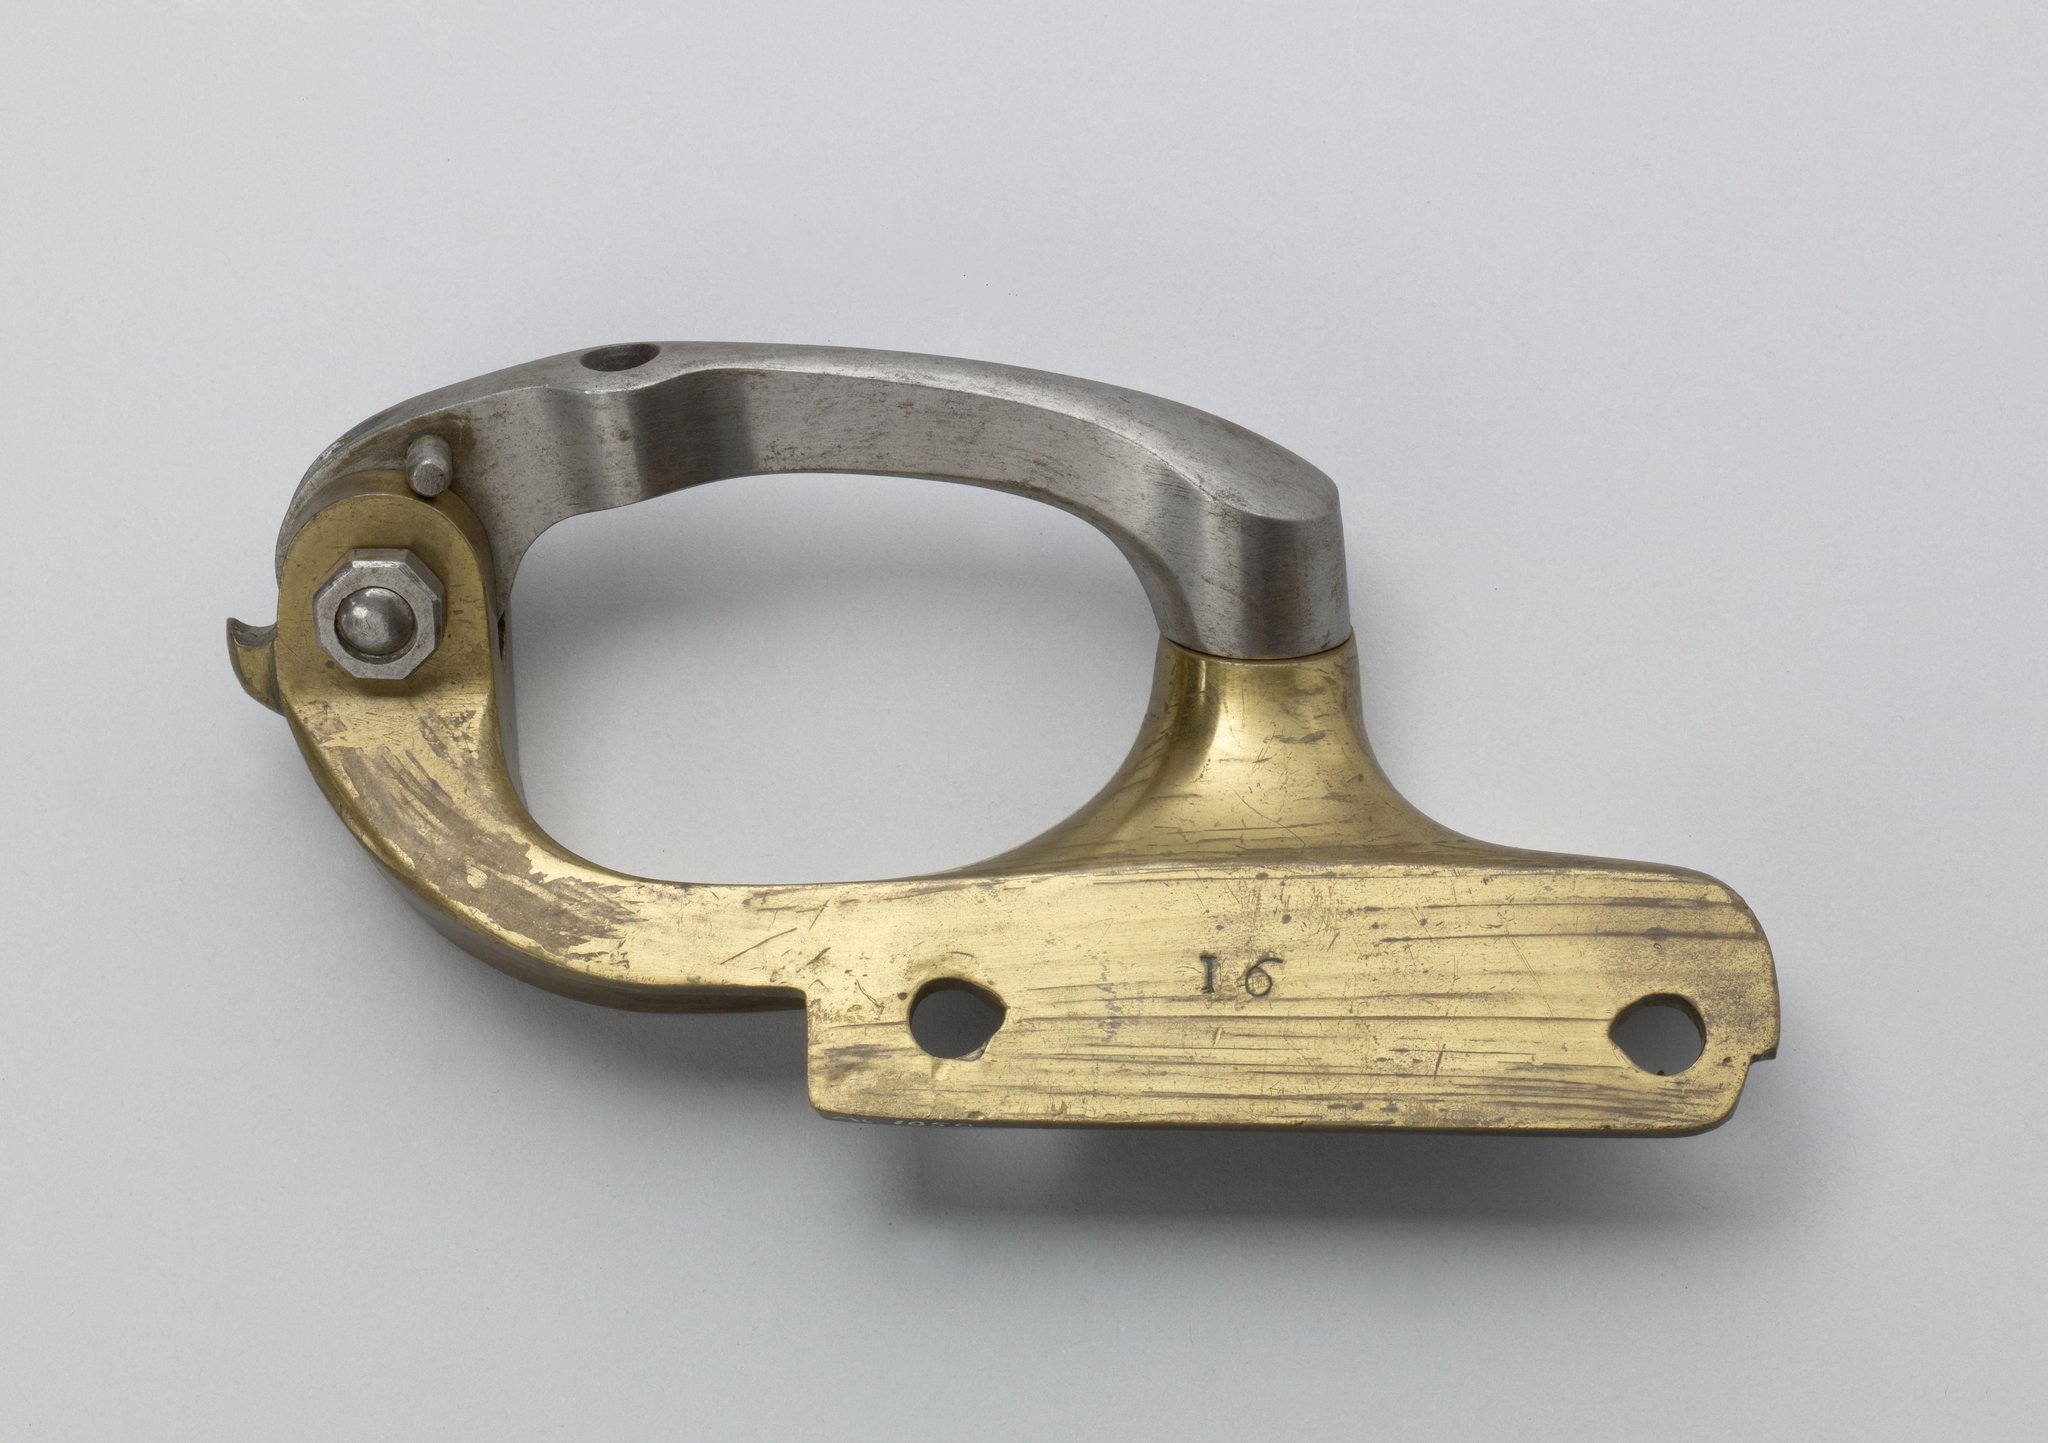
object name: percussion lock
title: Gun Lock (Percussion)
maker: Anonymous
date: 1840-1860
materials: brass, iron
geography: netherlands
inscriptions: inscription, on the lock: ‘16’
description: Percussieslot met messing huis en ijzeren hamer. Het huis moet in de lengterichting aan de rechterzijde tegen de slotverhevenheid bevestigd worden met twee bouten. De hamer draait om haar as tussen twee wangen en heeft een gat in de schacht voor het aftrektouw. Hij komt onder een hoek terecht op het slagpijpje, dat in een gat in het huis (het aambeeld) wordt gezet; de vlam komt aan de andere zijde het huis weer uit en komt in de pan terecht.